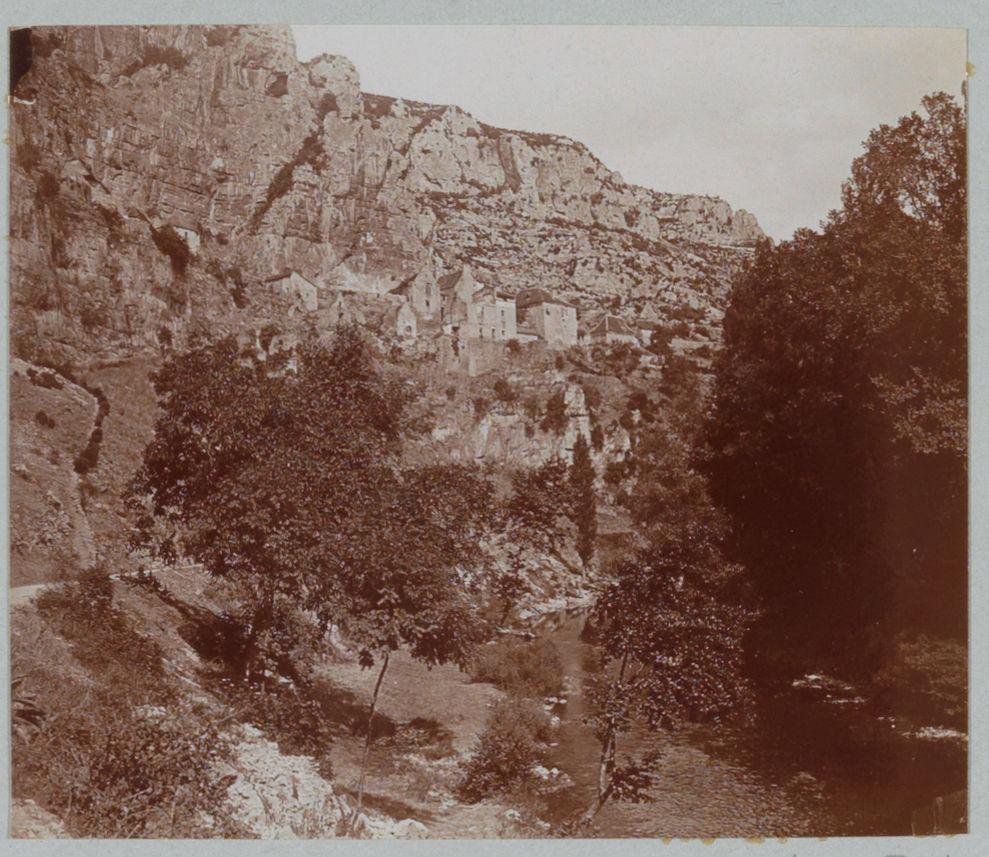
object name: photograph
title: Bergdorp tegen de rotsen in Frankrijk met op de voorgrond een rivieroever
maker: Anonymous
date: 1905-1910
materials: paper, photographic support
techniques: gelatin silver print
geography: france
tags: prospect of village, silhouette of village, river bank, mountains, france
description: Onderdeel van Fotoalbum van een Franse amateurfotograaf met bezienswaardigheden in Frankrijk, Zwitserland en Italië.